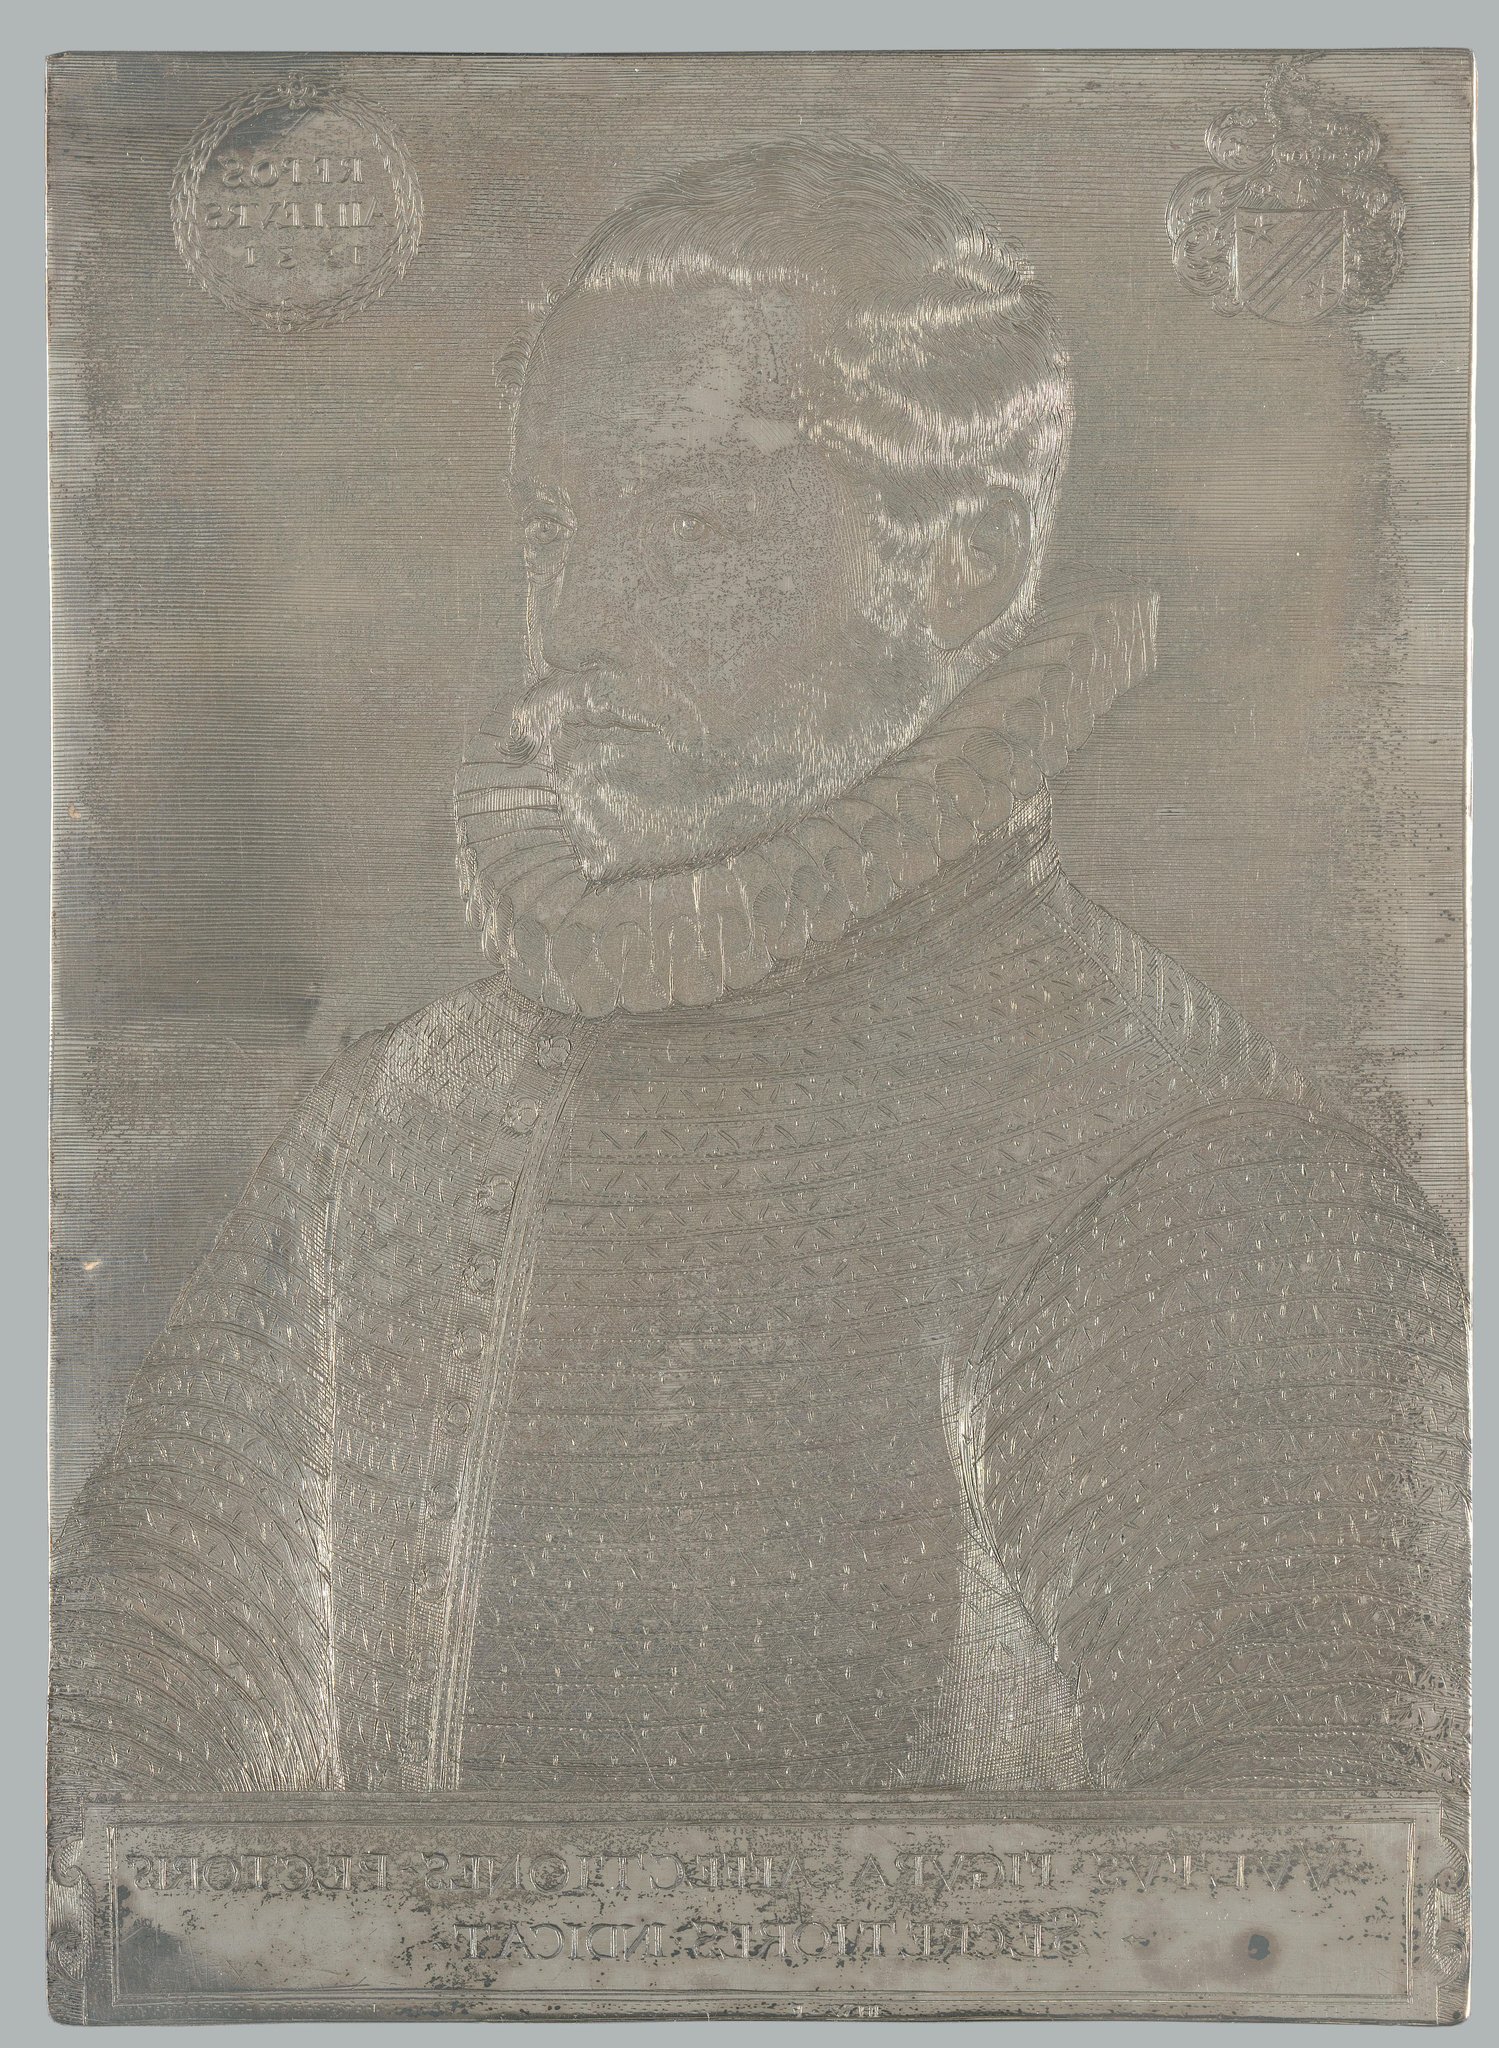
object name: zilverplaat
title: Portret van Filips van Marnix van Sint-Aldegonde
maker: johannes wierix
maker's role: draughtsman, print maker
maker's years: 1549-1618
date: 1581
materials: silver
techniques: engraving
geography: antwerp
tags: brussels, filips van marnix van sint-aldegonde, historical persons, portrait of a writer, (diplomat) presenting credentials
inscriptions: caption: ‘Vultus Figura affectiones Pectoris / Secretiores indicat’, inscription: ‘Repos ailleurs’, date: ‘1581’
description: Zilveren plaatje met portret Marnix van Sint-Aldegonde (1540-1598) op 41-jarige leeftijd . Buste naar links. Linksboven cartouche met tekst 'Repos ailleurs' en jaartal 1581 (in spiegelbeeld). Rechtsboven wapen. Met onderschrift.